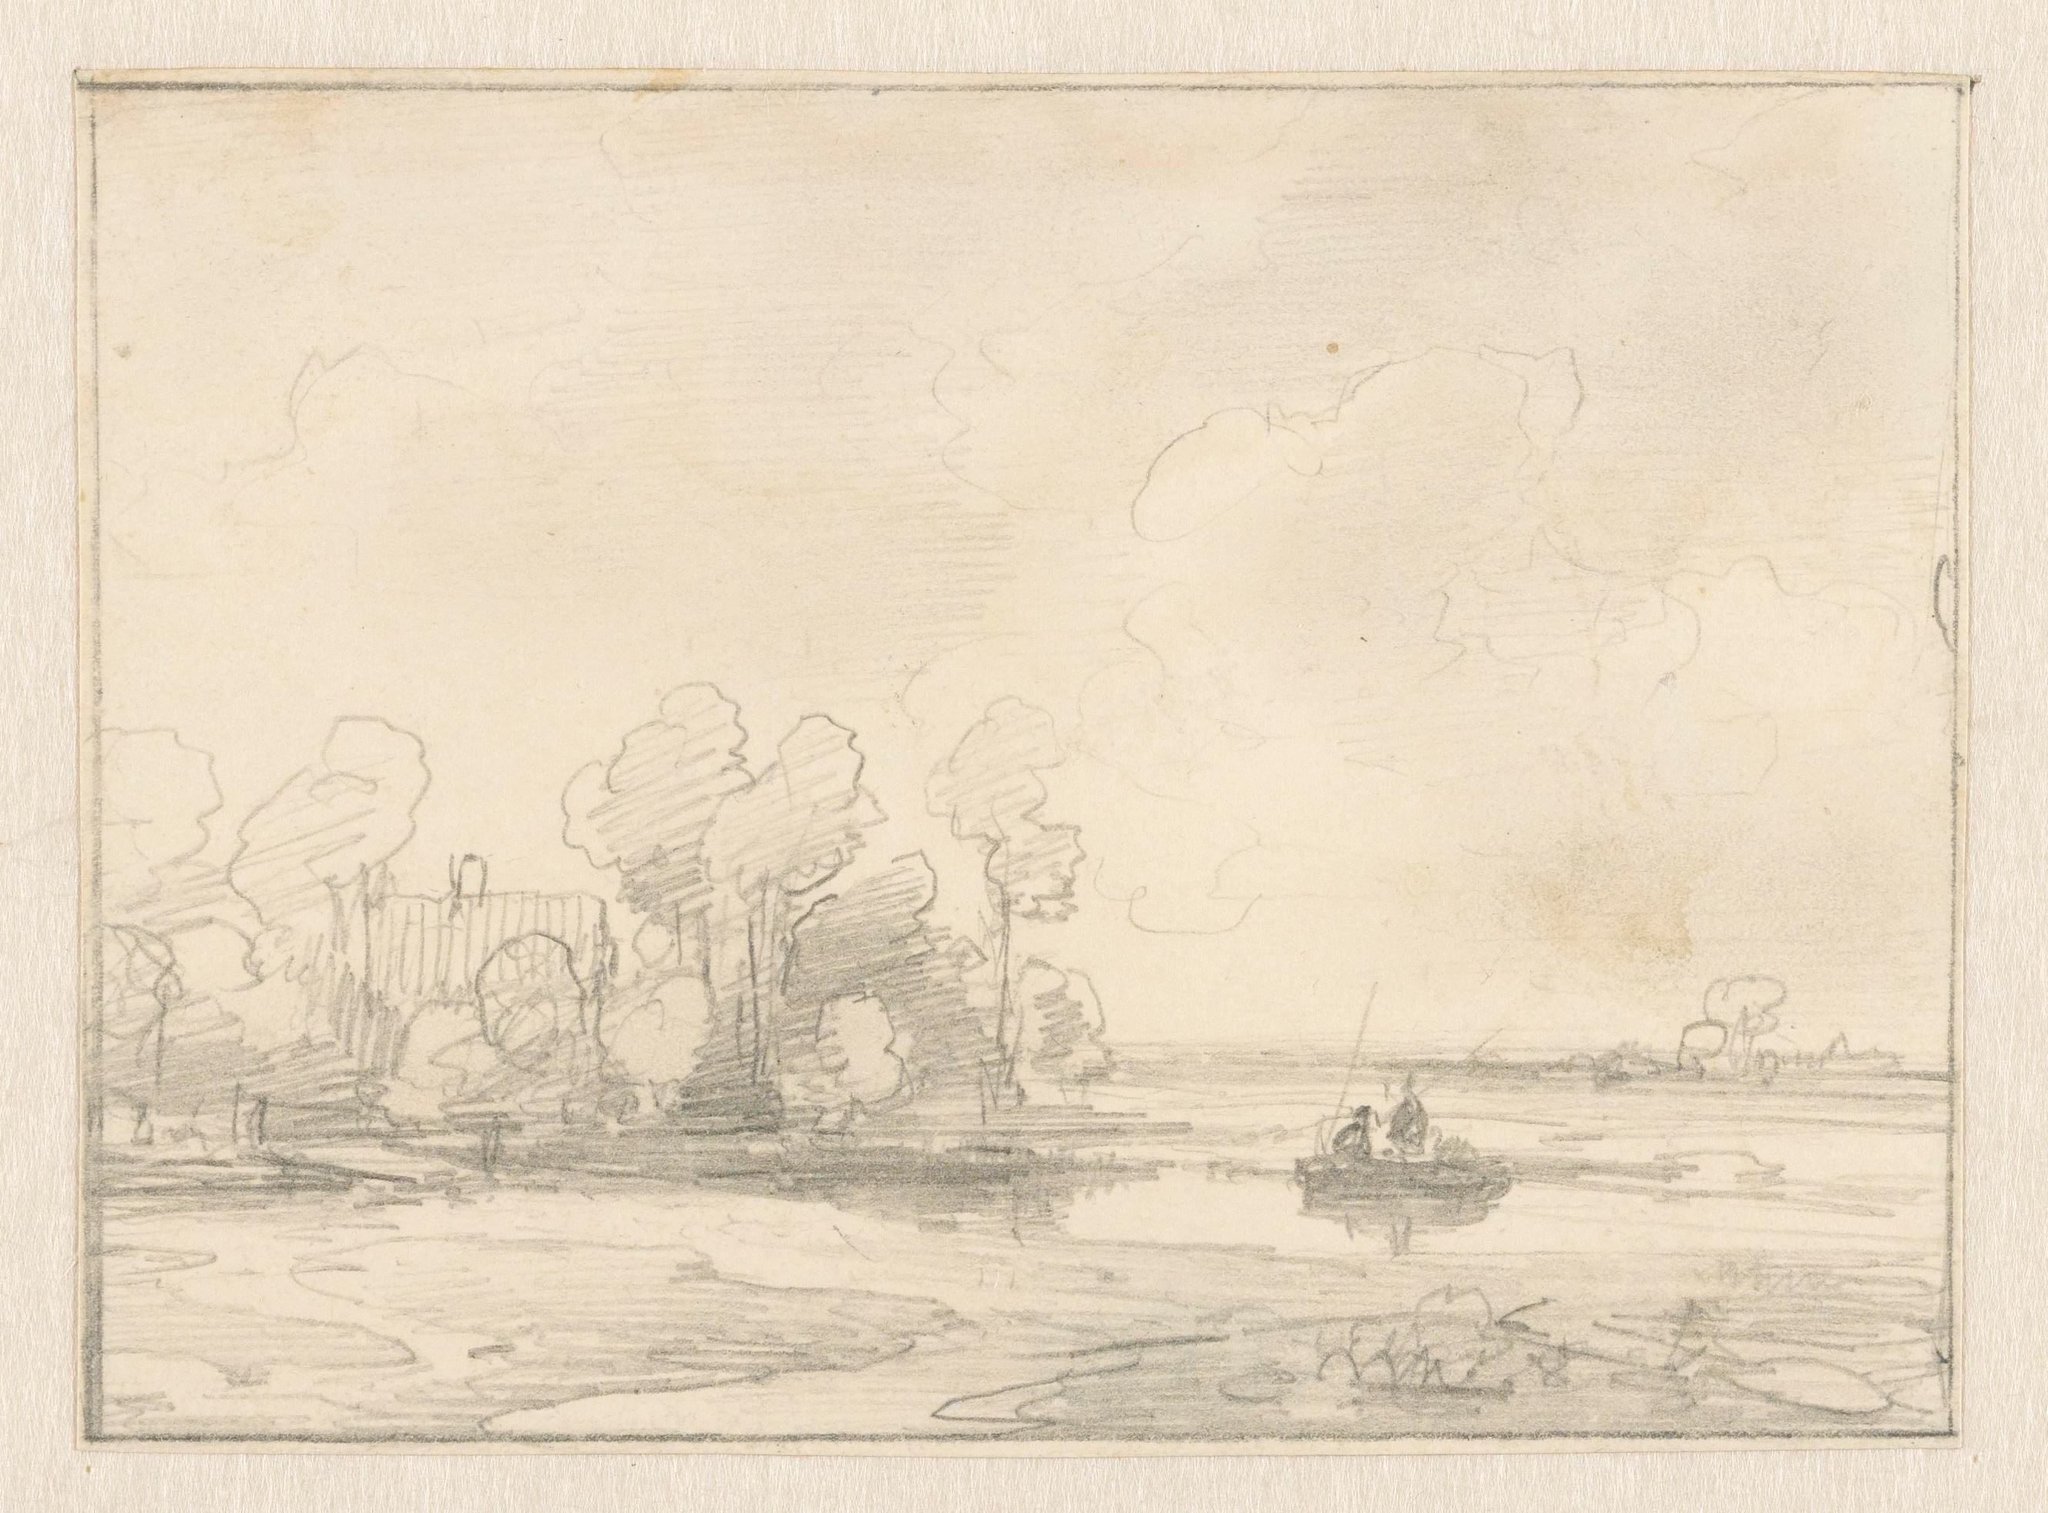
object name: drawing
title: Landschap met huis omringd door bomen aan het water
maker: andreas schelfhout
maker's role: draughtsman, painter, print maker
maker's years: 1787-1870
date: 1797-1870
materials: paper, pencil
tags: rowing-boat, canoe, etc., farm or solitary house in landscape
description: Landschap met huis omringd door bomen aan het water met twee vissers in een bootje.